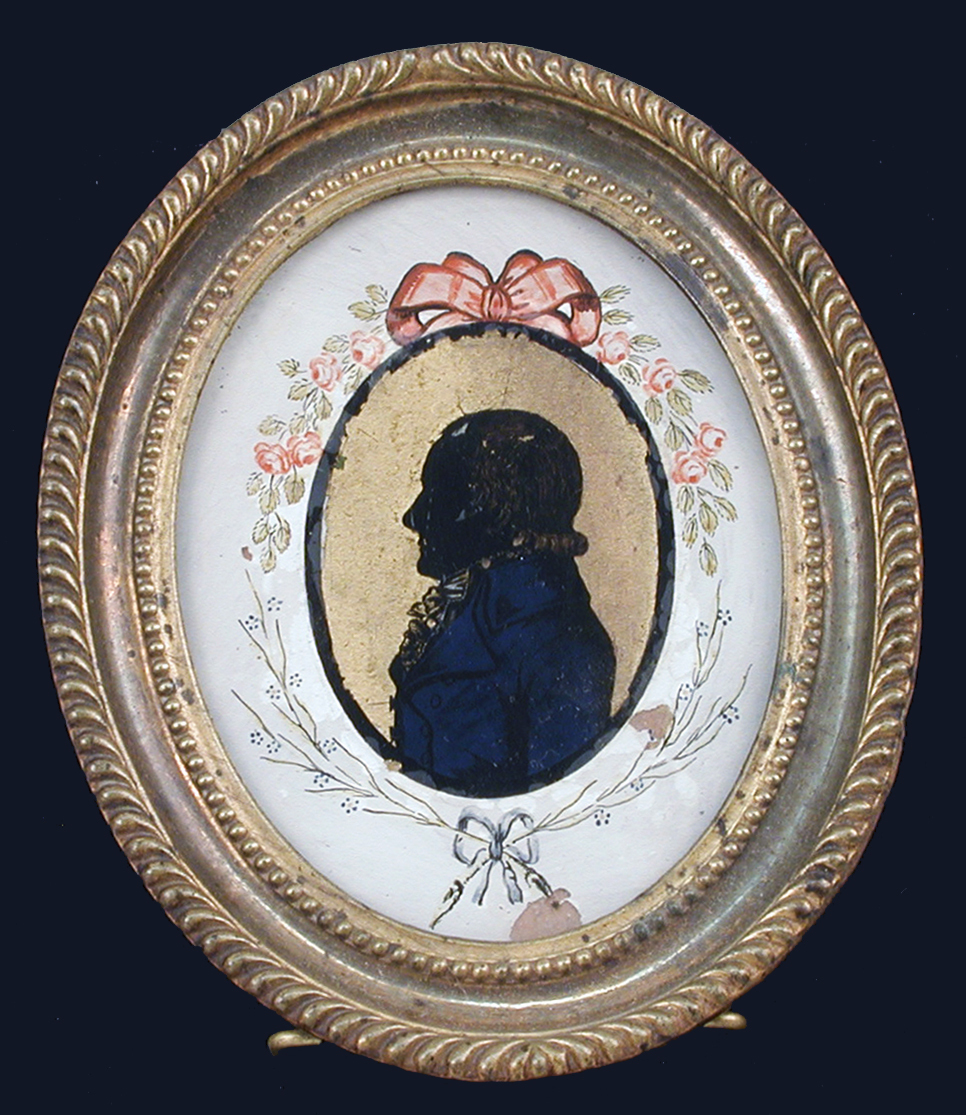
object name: medallion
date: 1801-1900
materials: glass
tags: men,profiles,flowers